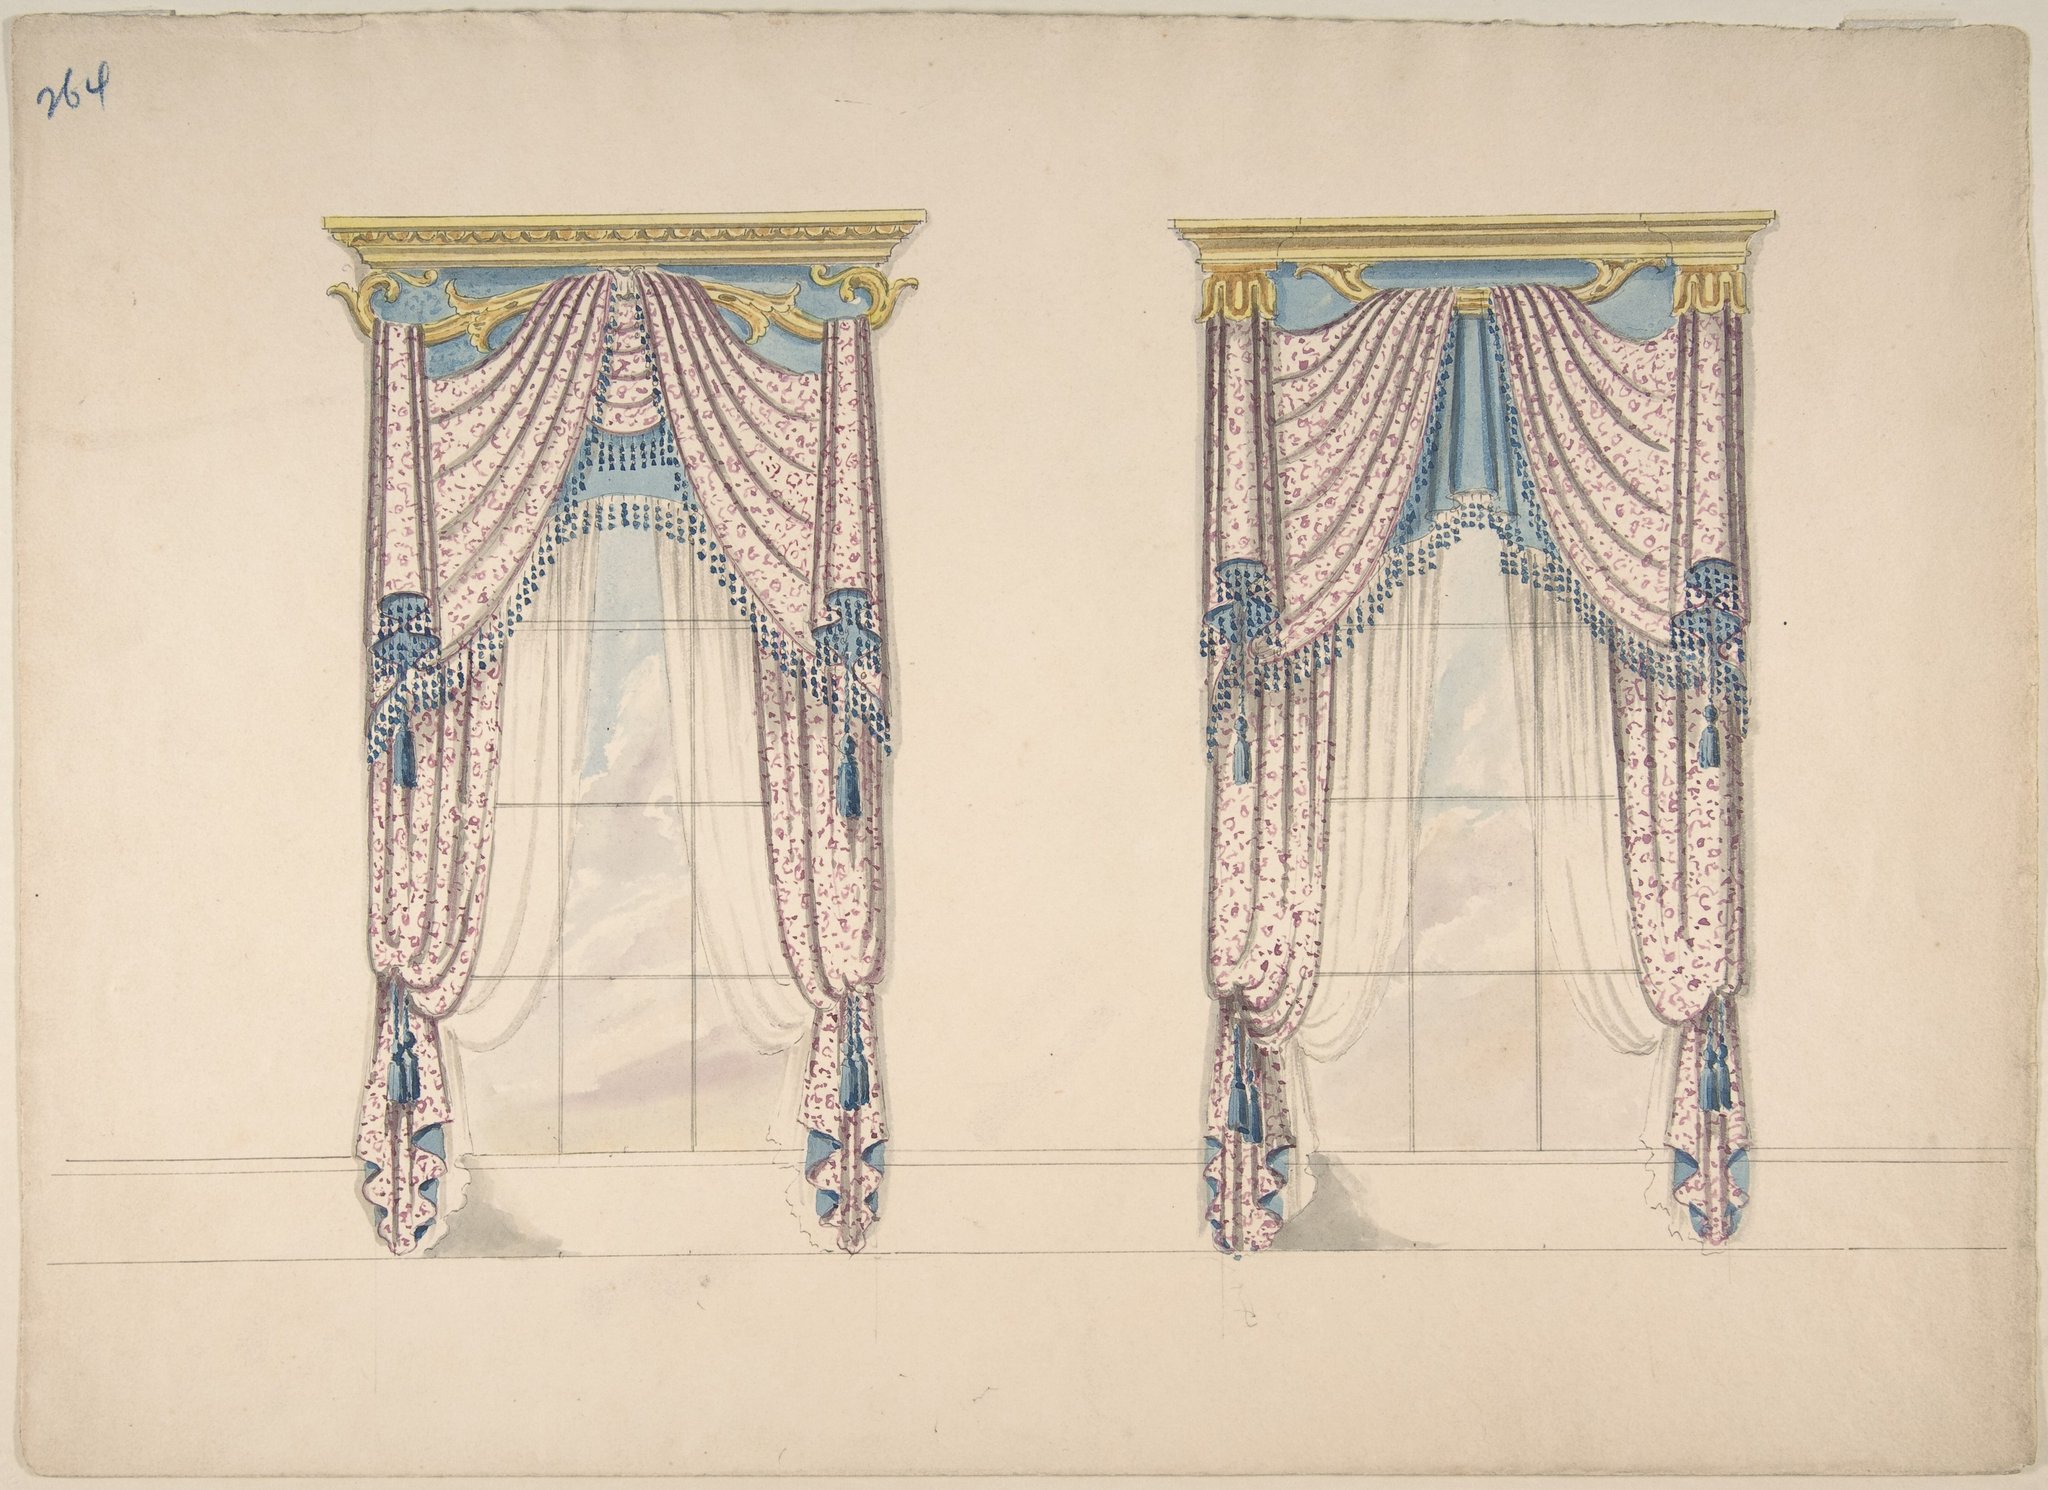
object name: drawing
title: Design for Pink, White and Blue Curtains with Blue Fringes, and Gold and Blue Pediments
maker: anonymous, british, 19th century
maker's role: artist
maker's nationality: british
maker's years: 1800-1900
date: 1820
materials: ink, watercolor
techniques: brush, pen, wash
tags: curtains